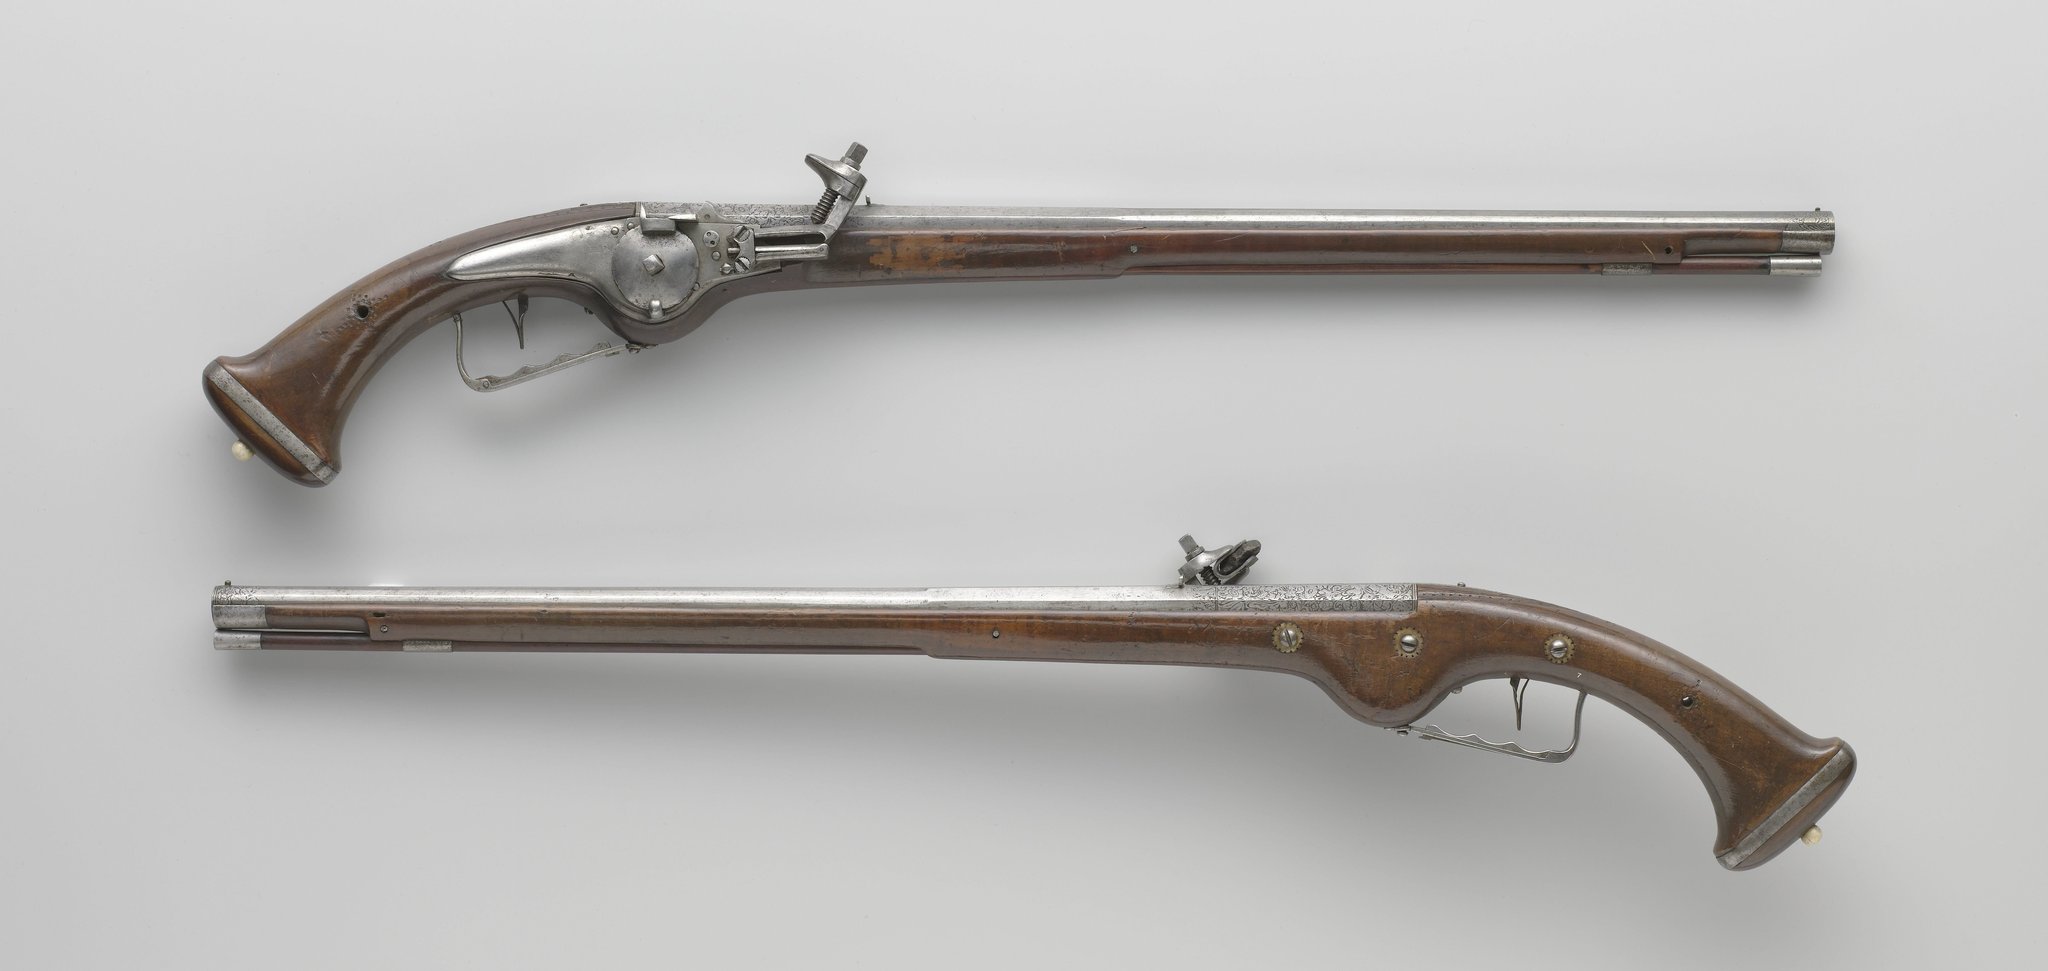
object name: radslotpistool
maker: adolf bosch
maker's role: geweermaker, pistoolmaker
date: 1650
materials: wood, horn, iron, ivory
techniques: printing, pierced, punching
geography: den bosch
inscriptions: mark: ‘A; B’